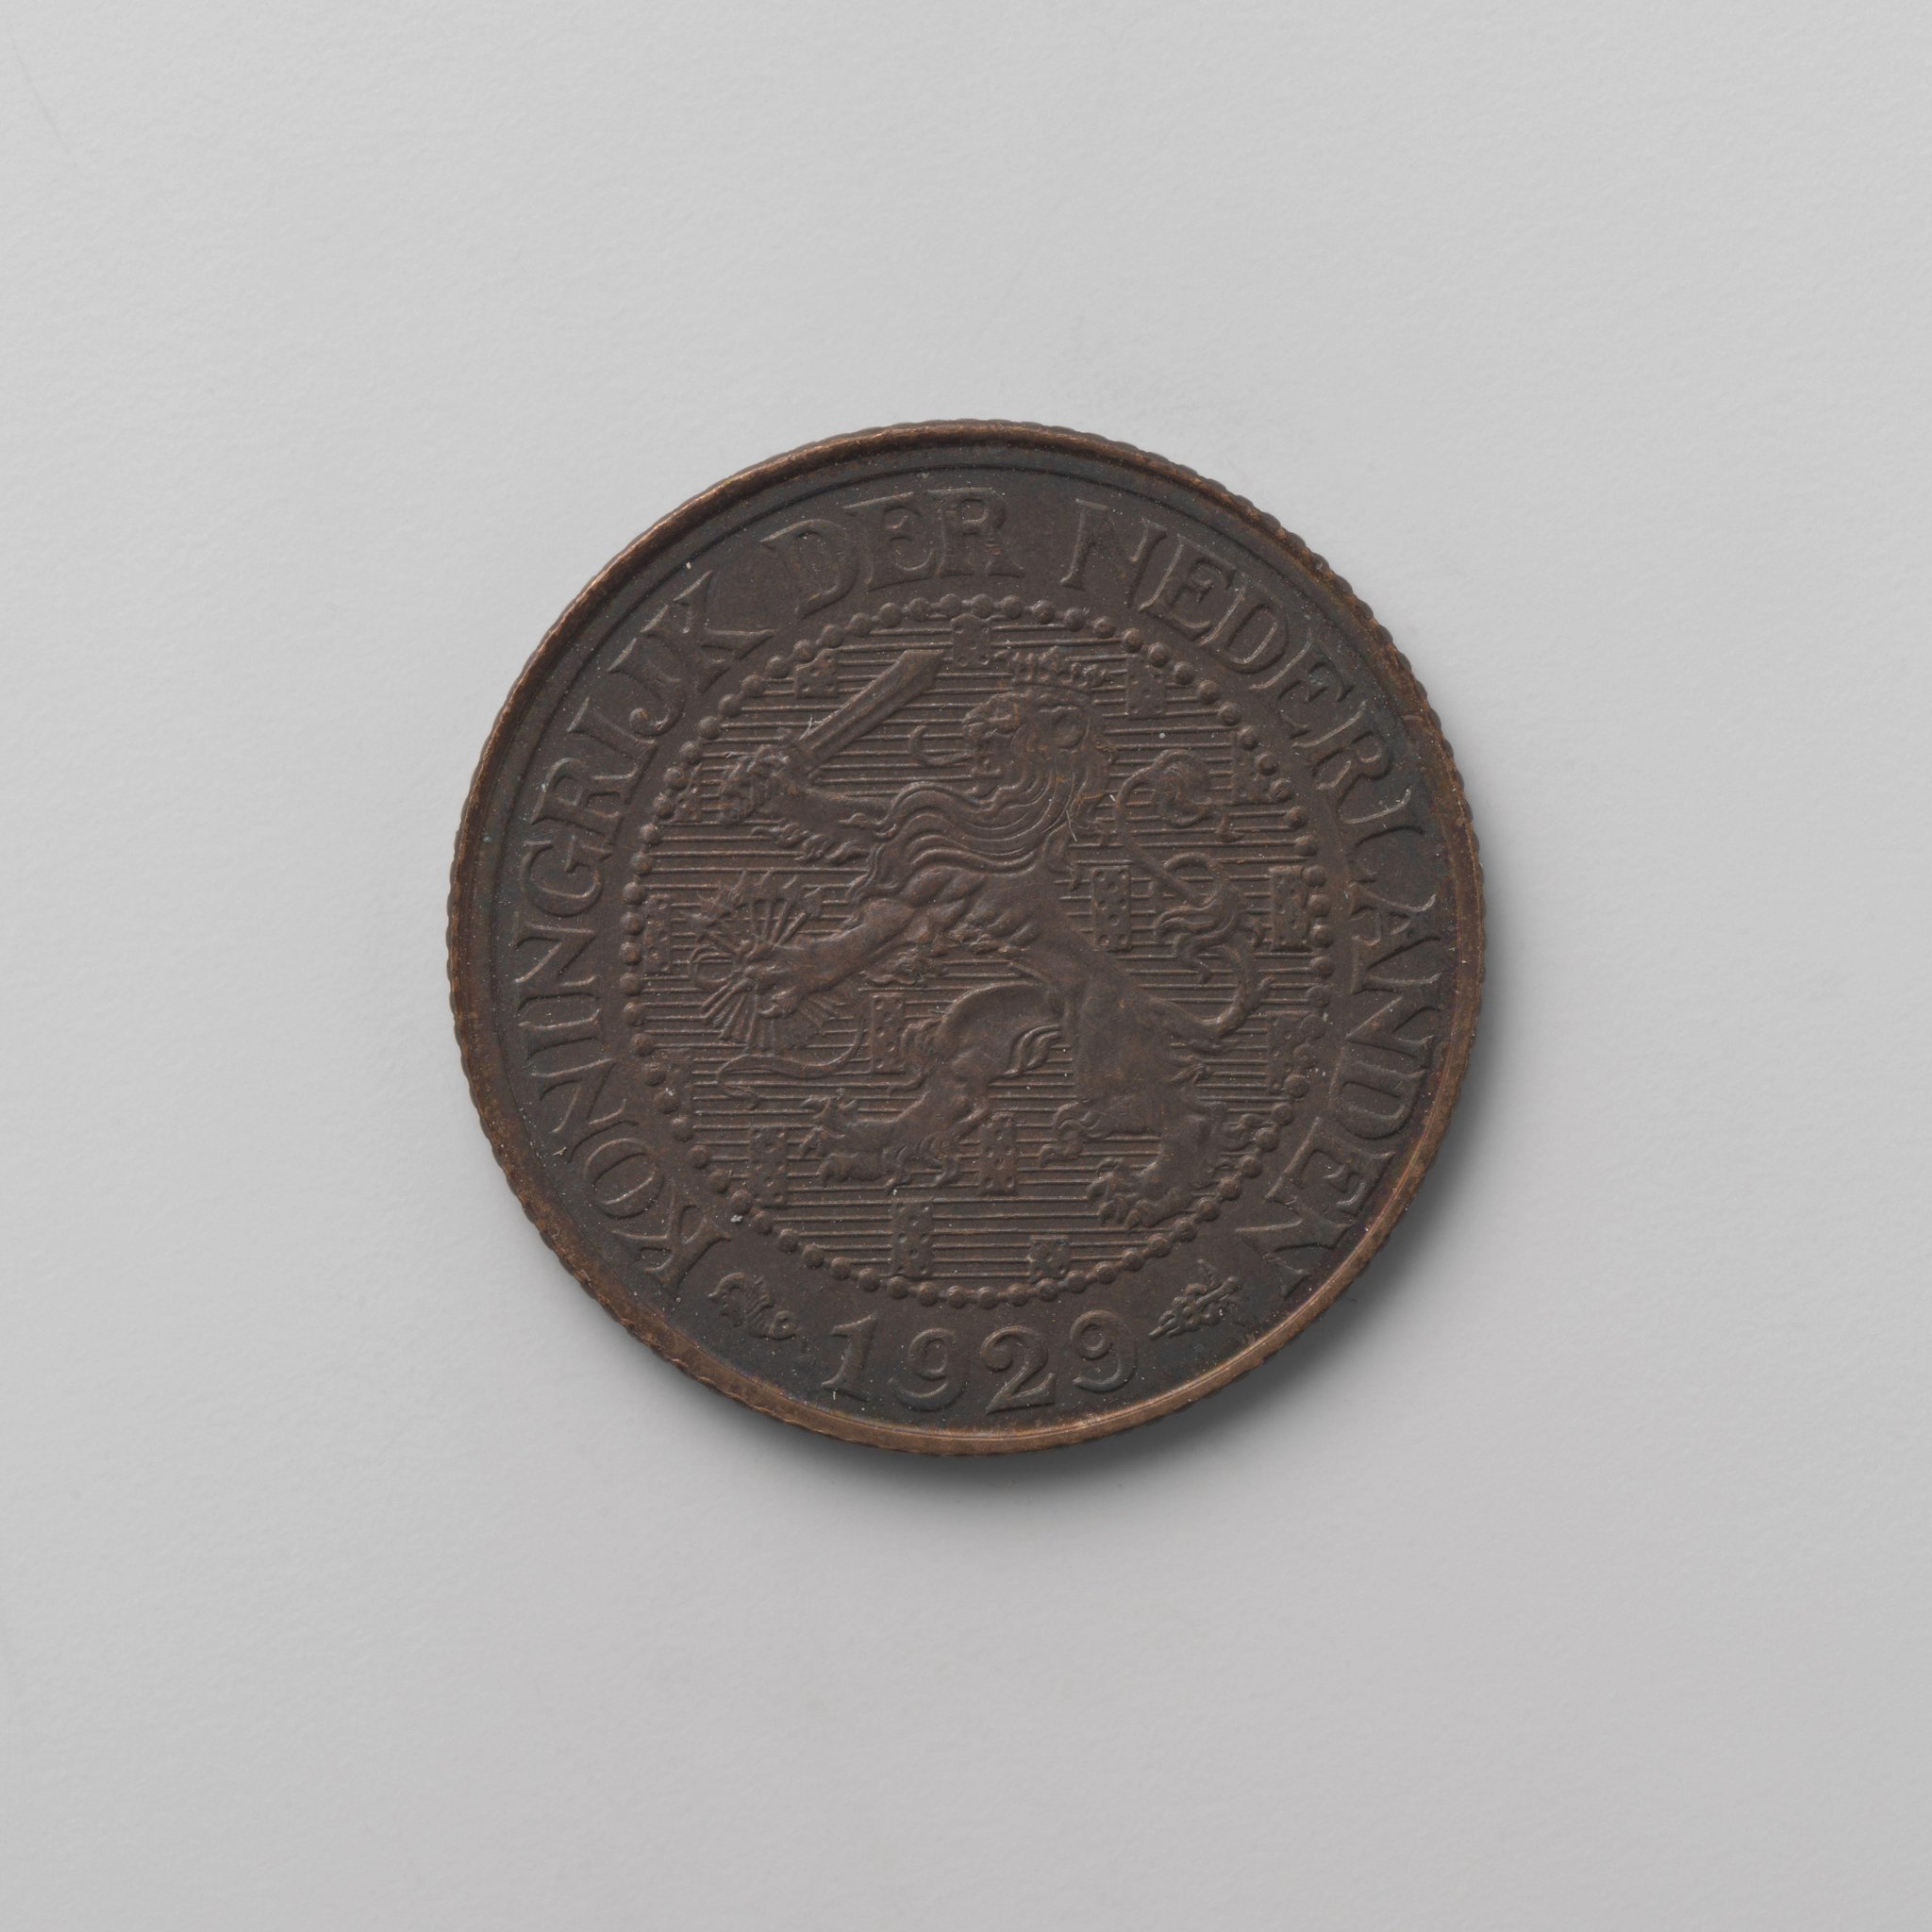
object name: coin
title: Nederland, 2½ cent,1929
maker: wilhelmina of the netherlands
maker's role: print maker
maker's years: 1880-1962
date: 1929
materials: bronze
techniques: striking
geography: utrecht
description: Bronzen munt. Voorzijde: in een veld rijkswapen. Jaartal onderaan in omschrift.Keerzijde: binnen twee samengebonden oranjetakken waarde-aanduiding 2½ cent. Kartelrand.